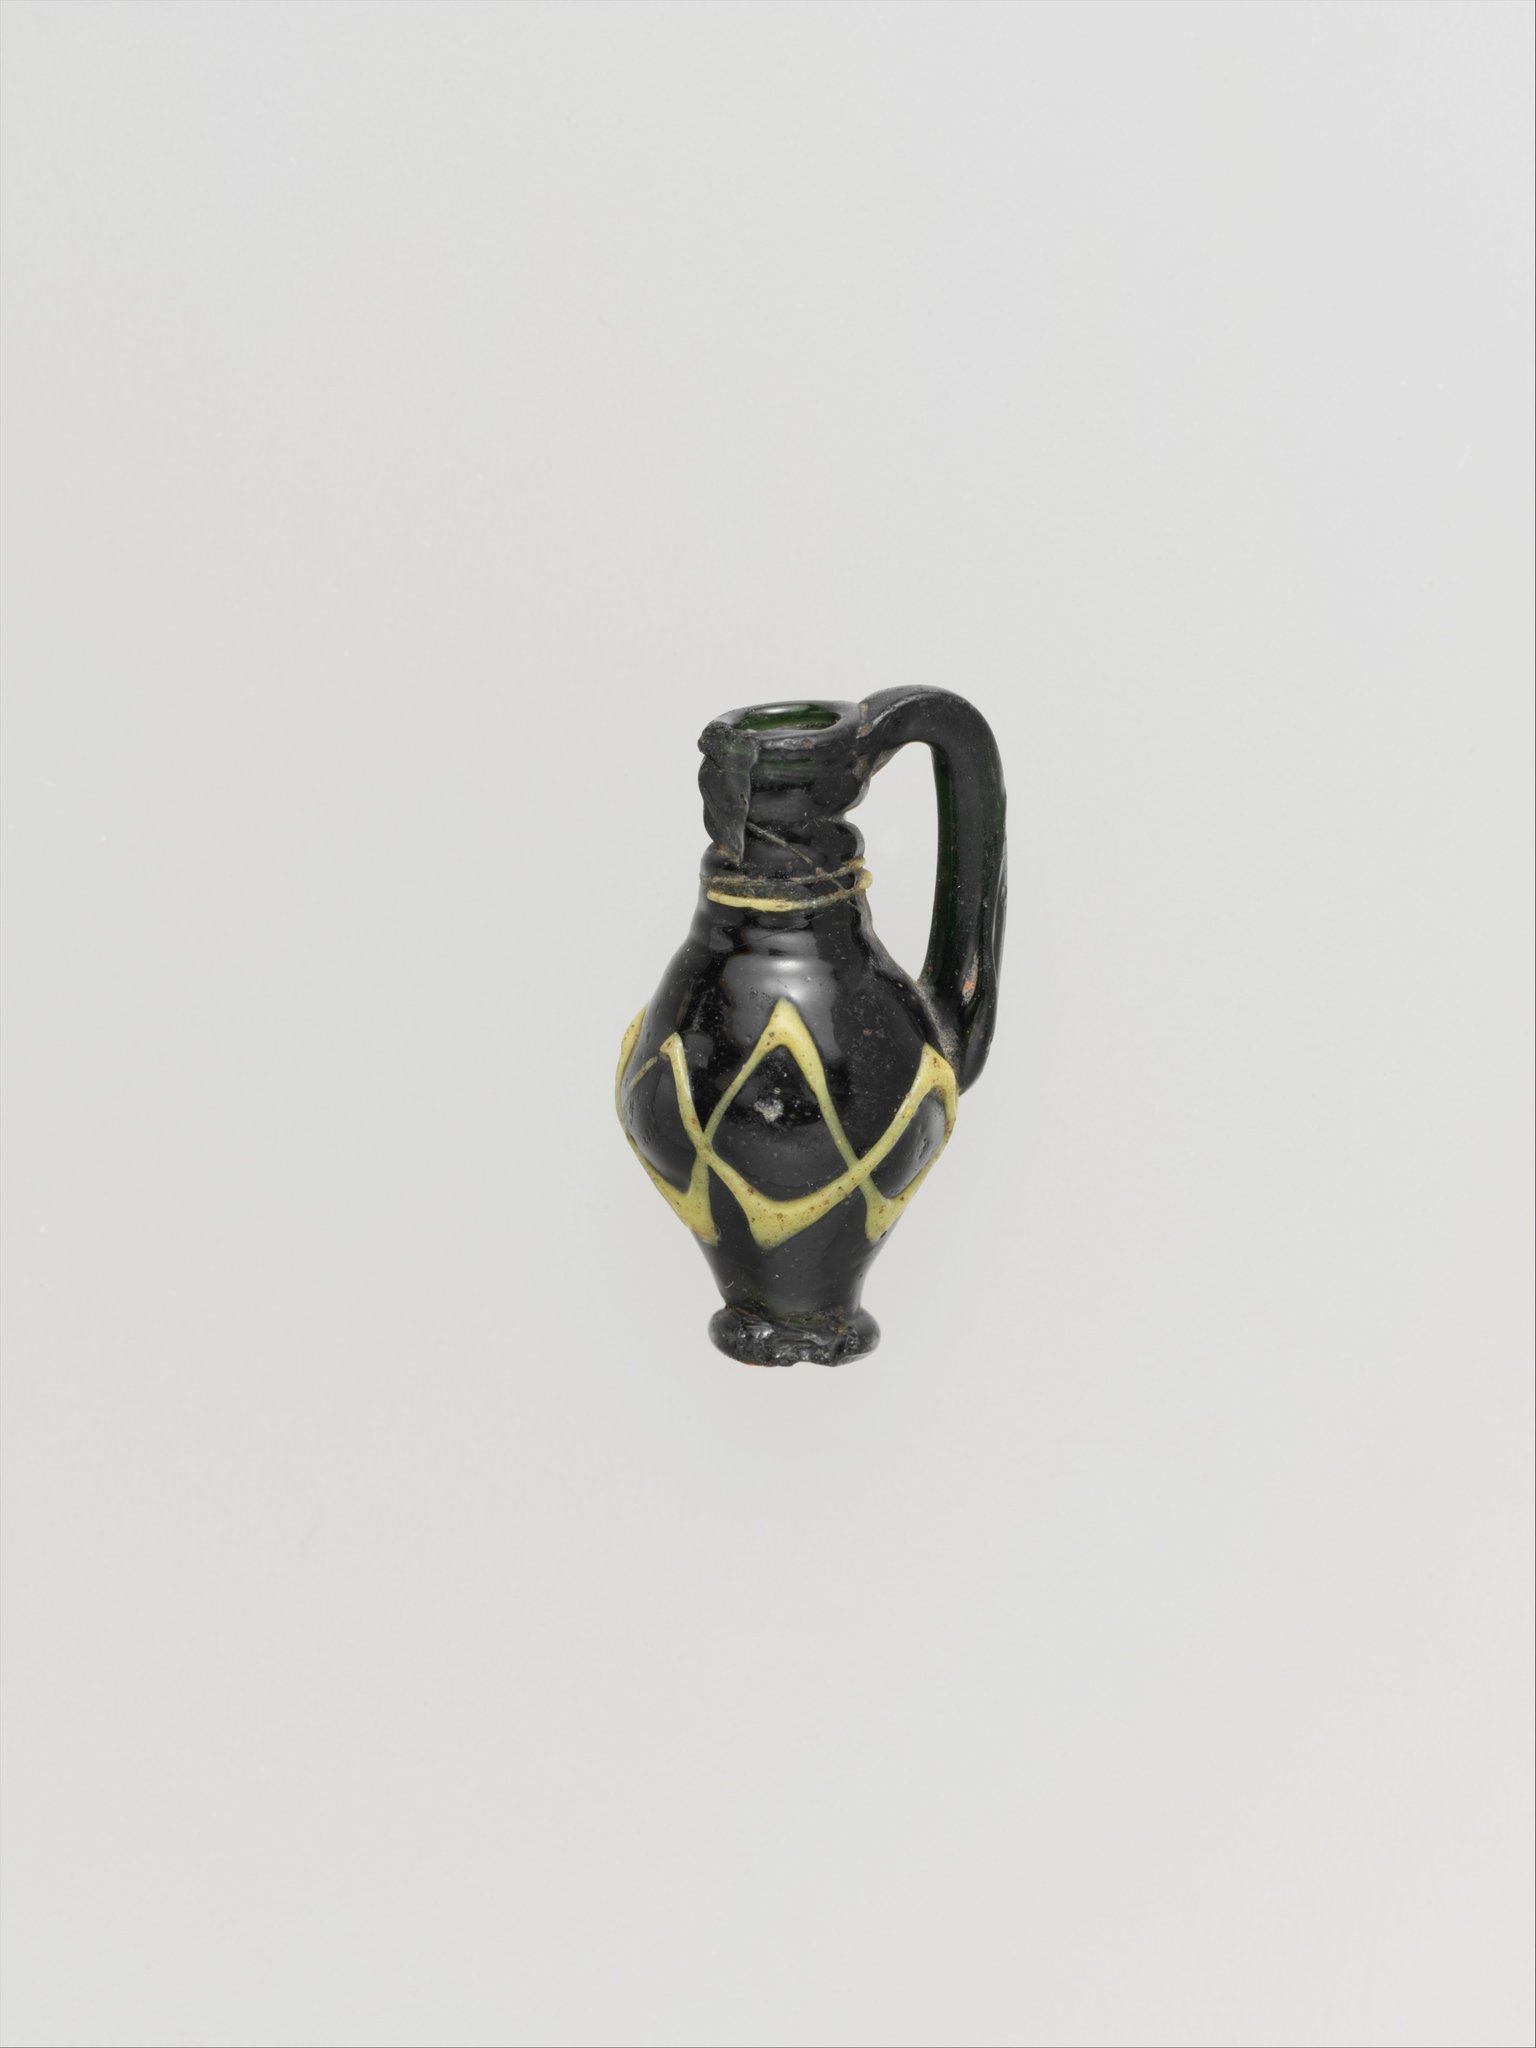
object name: pendant in the form of a miniature jug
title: Glass pendant in the form of a miniature jug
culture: roman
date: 301-500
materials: glass